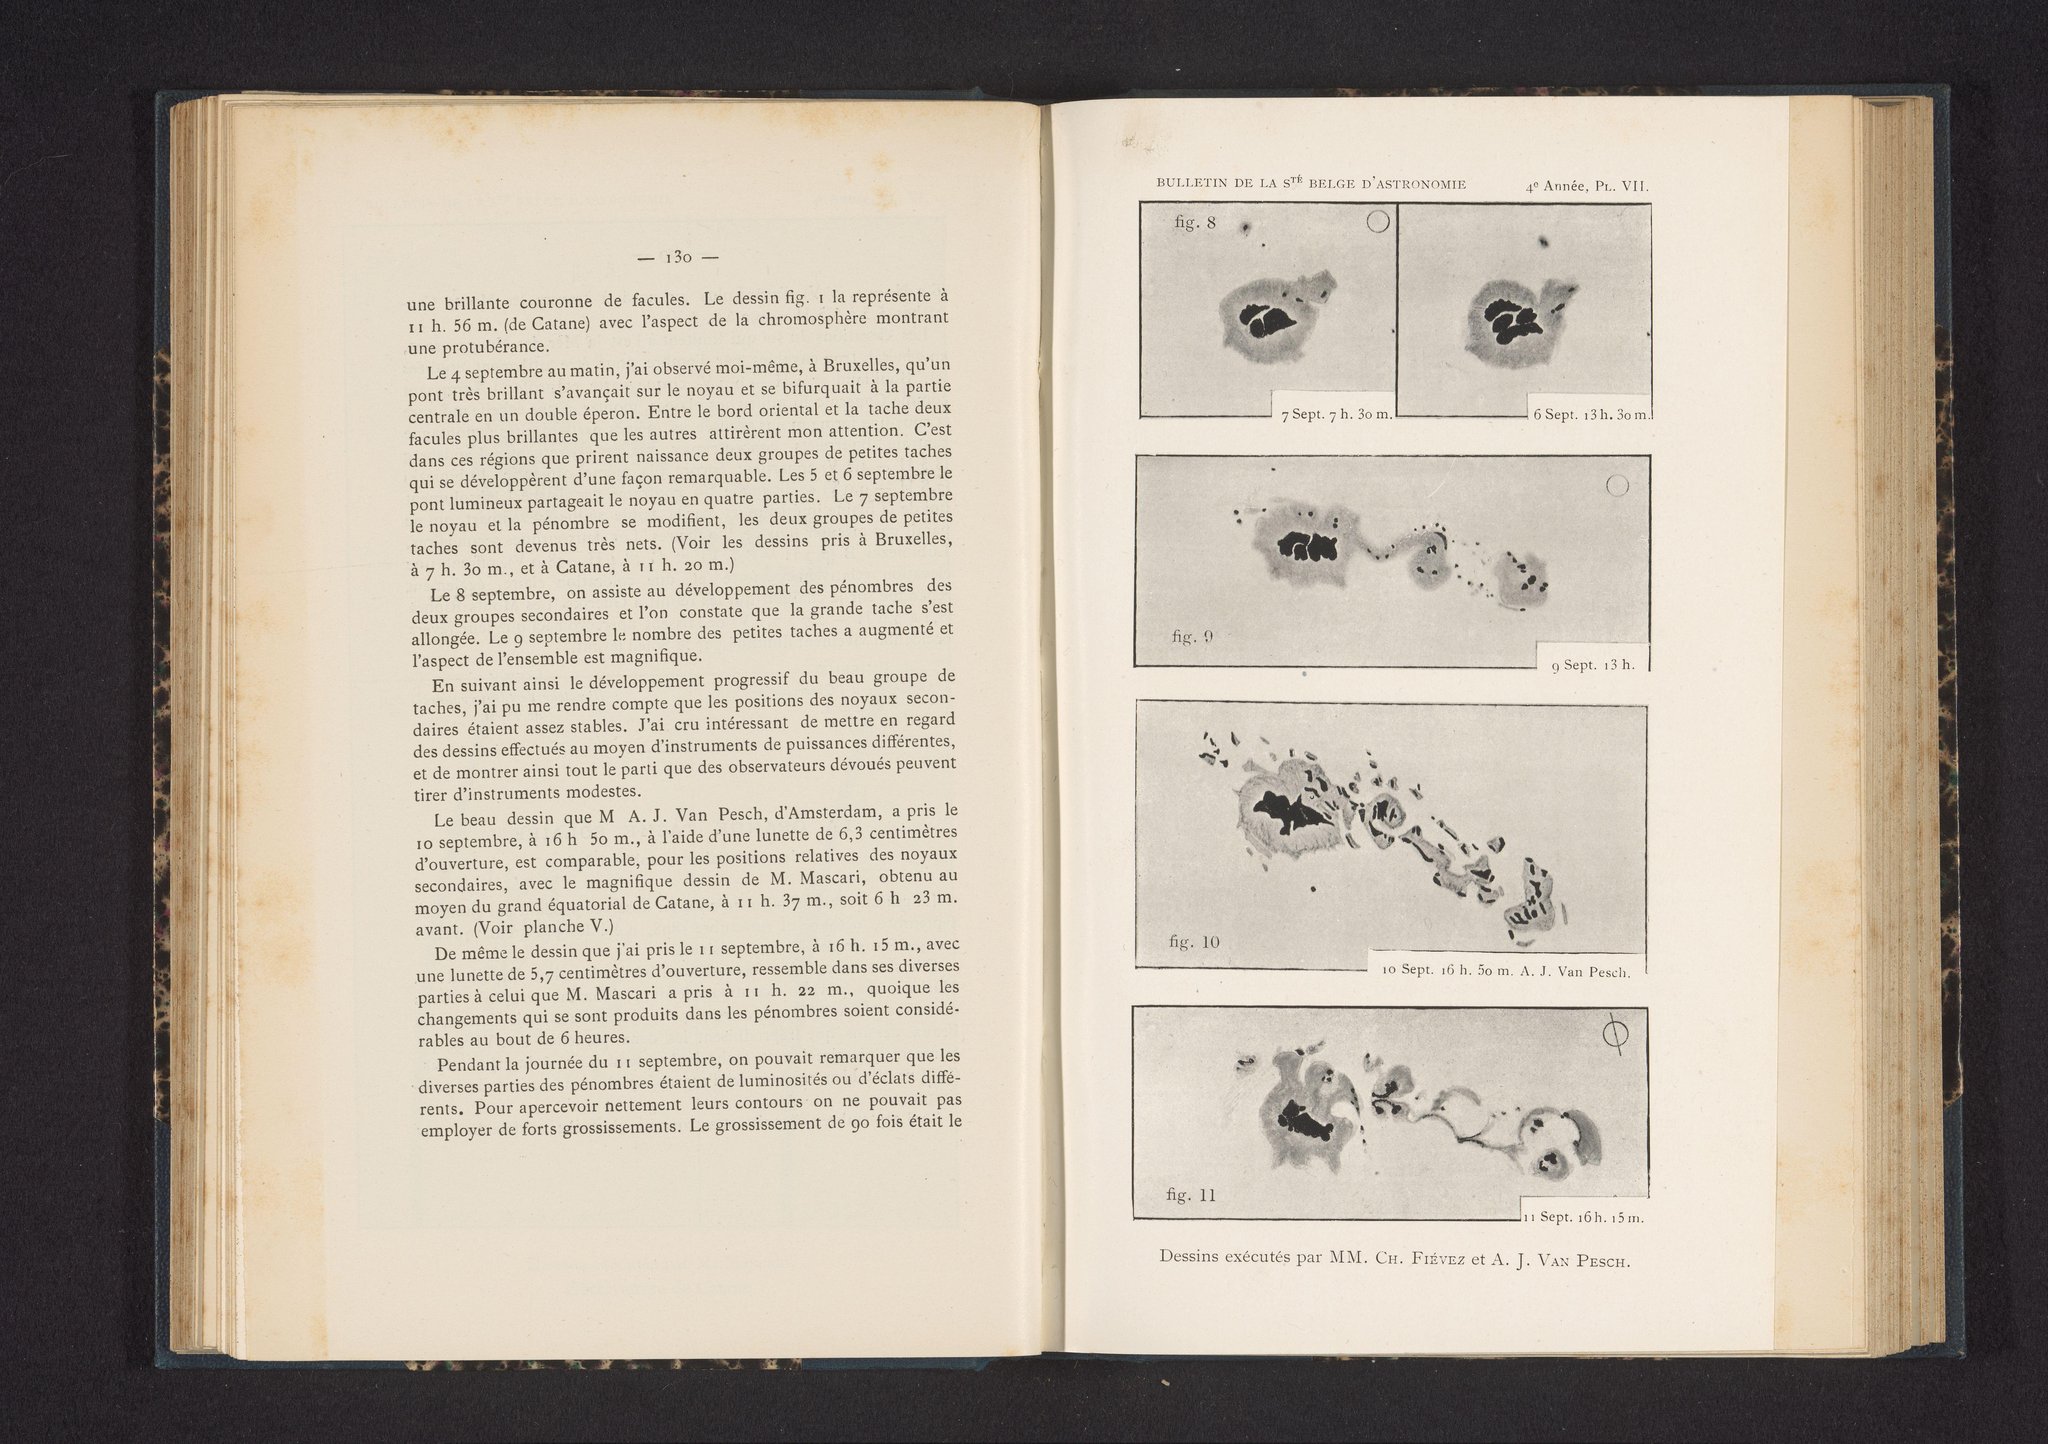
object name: photomechanical print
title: Vijf opnames van zonnevlekken door het observatorium van Catane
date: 1894-1899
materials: paper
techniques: autotype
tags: sun-spots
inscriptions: inscription: ‘4e Année, Pl. VII’